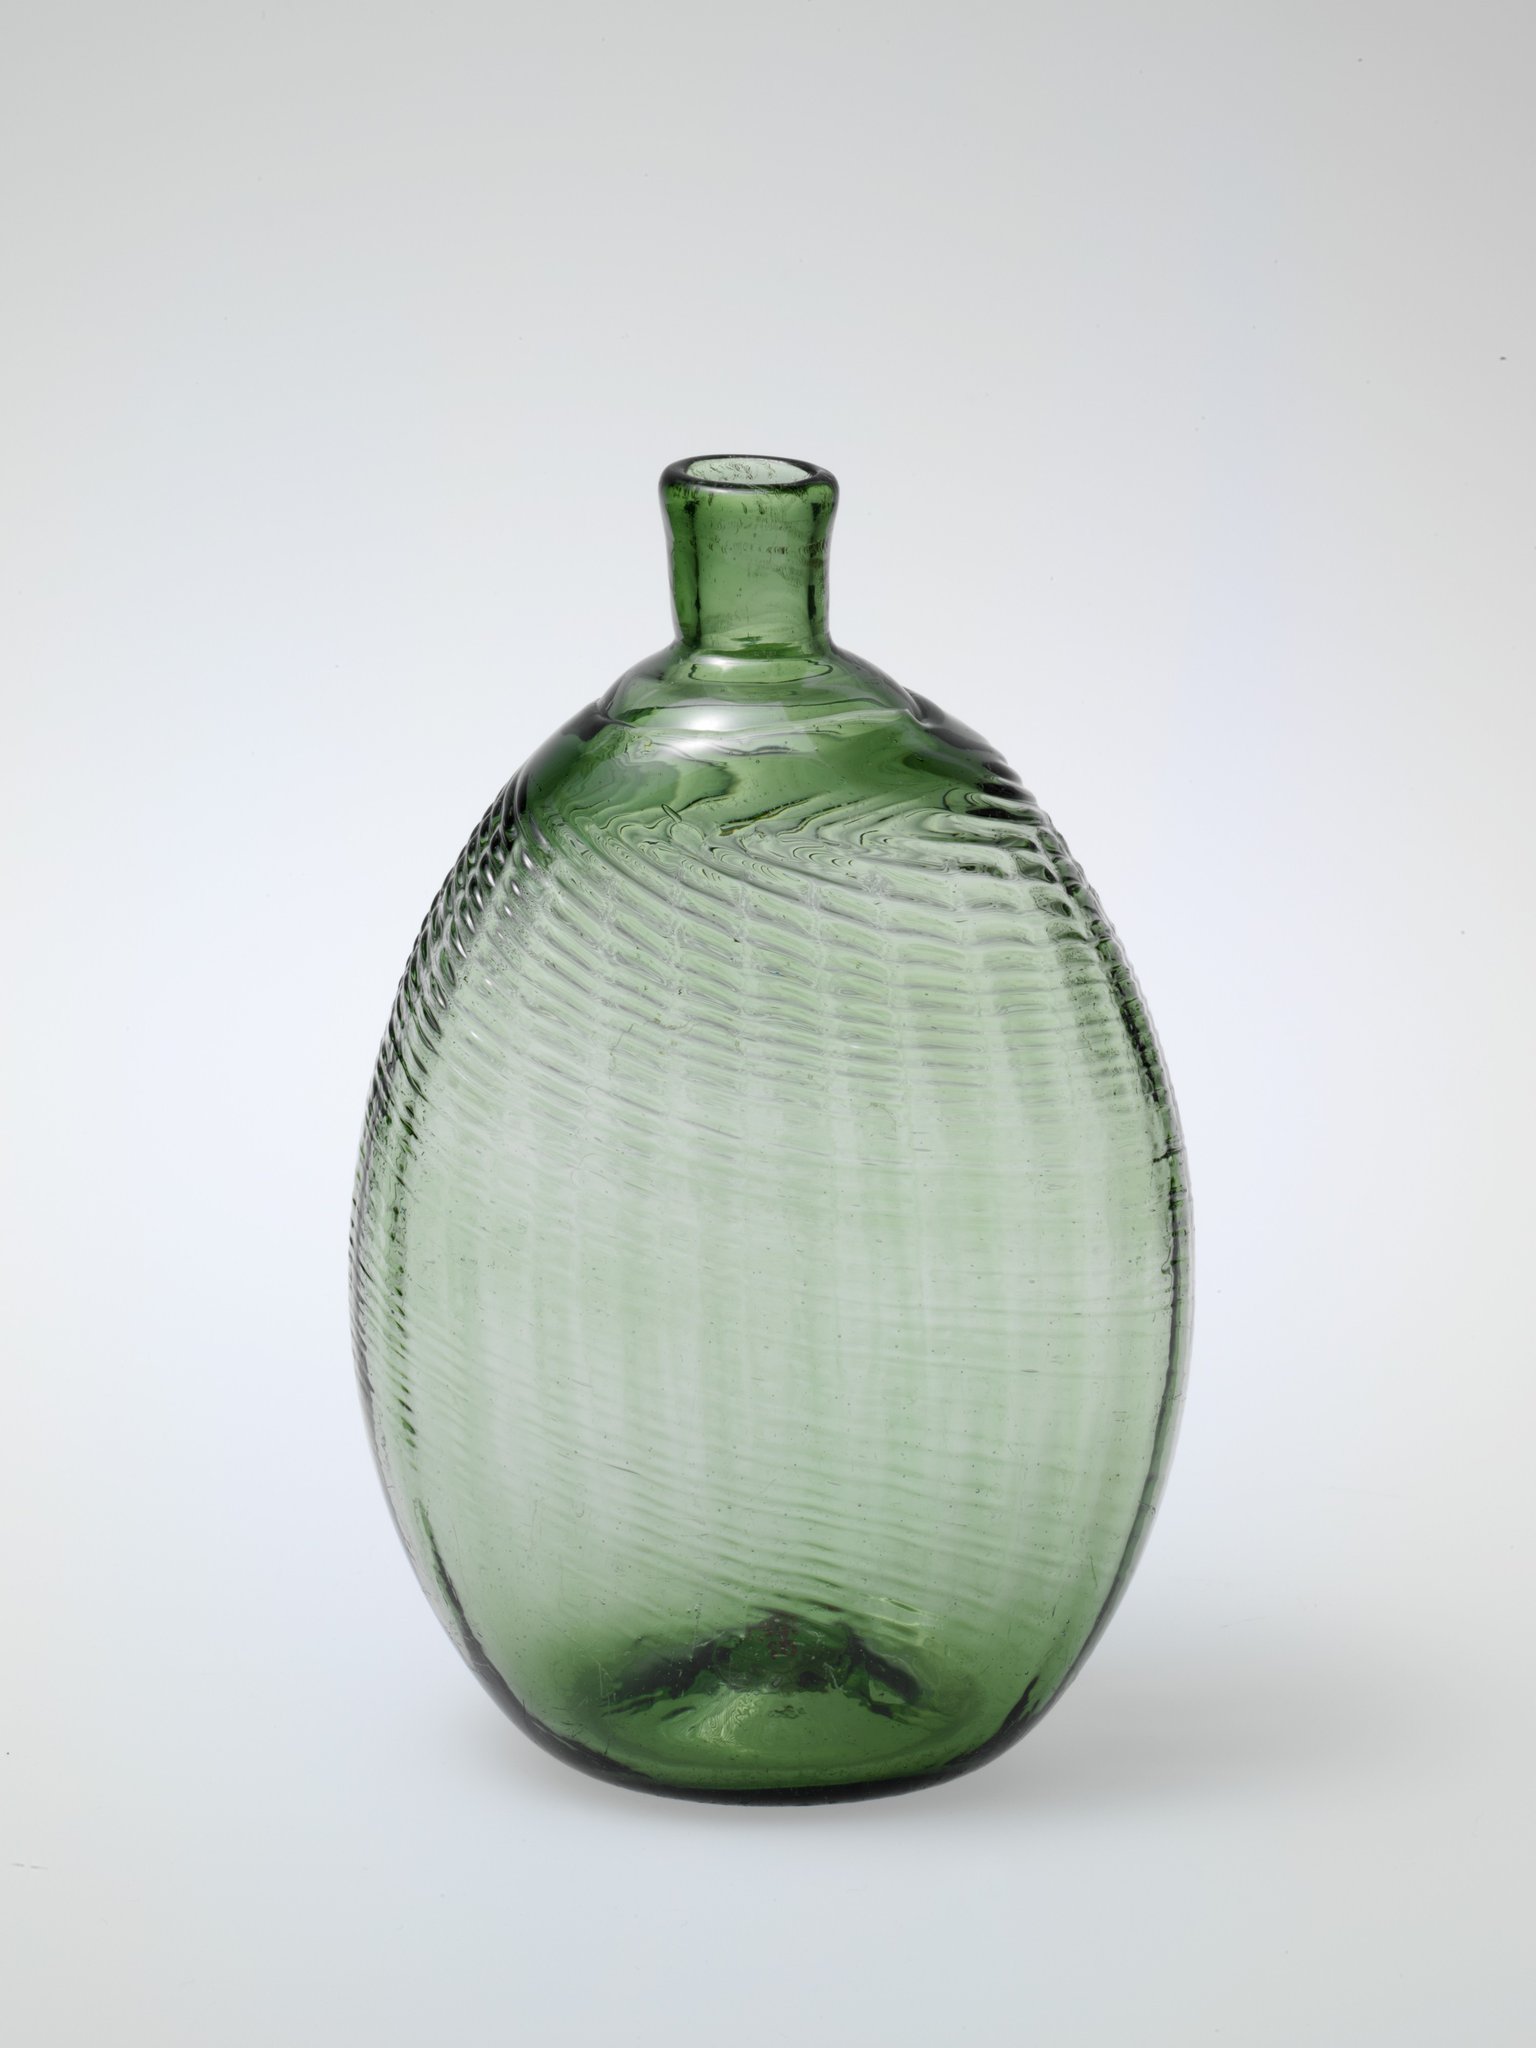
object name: pocket bottle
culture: american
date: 1815-1845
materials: glass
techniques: glassblowing, molding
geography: united states